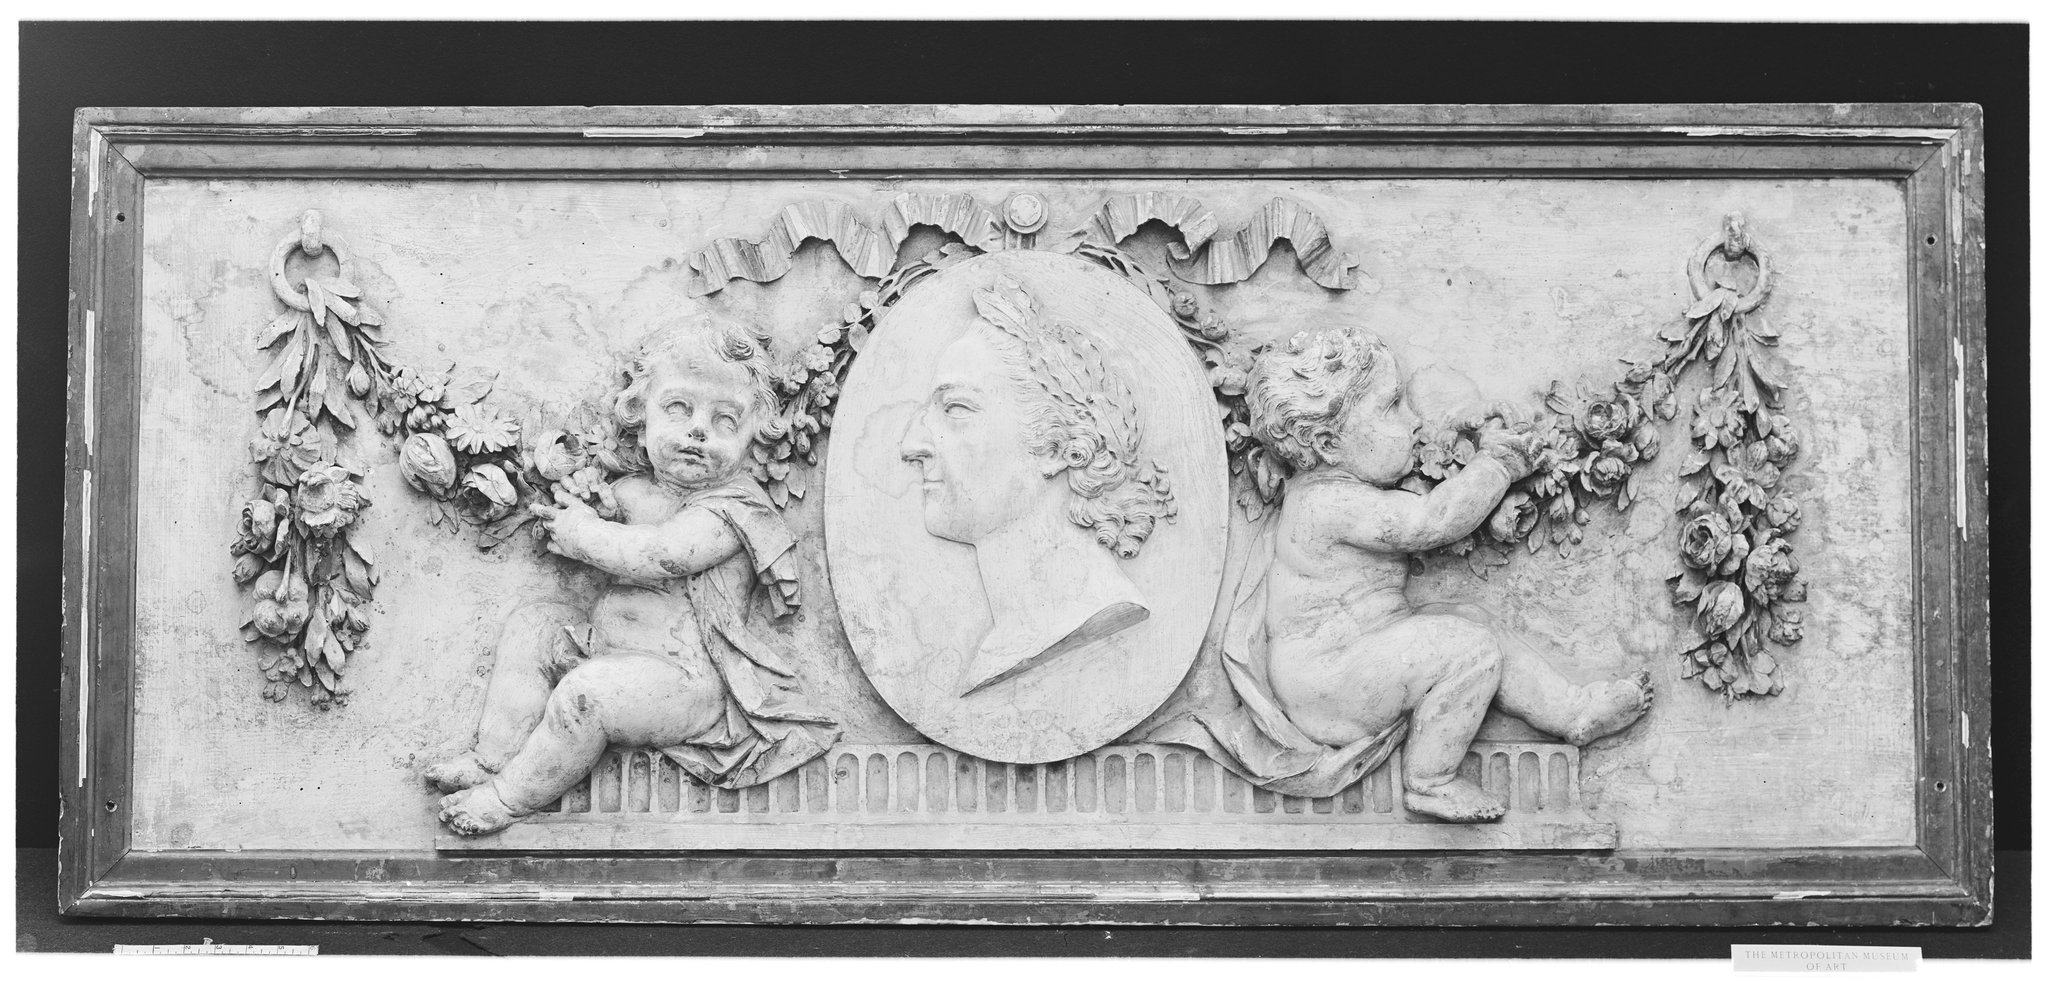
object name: overdoor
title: Pair of overdoors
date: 1770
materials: wood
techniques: carving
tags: garlands,children,men,portraits,profiles